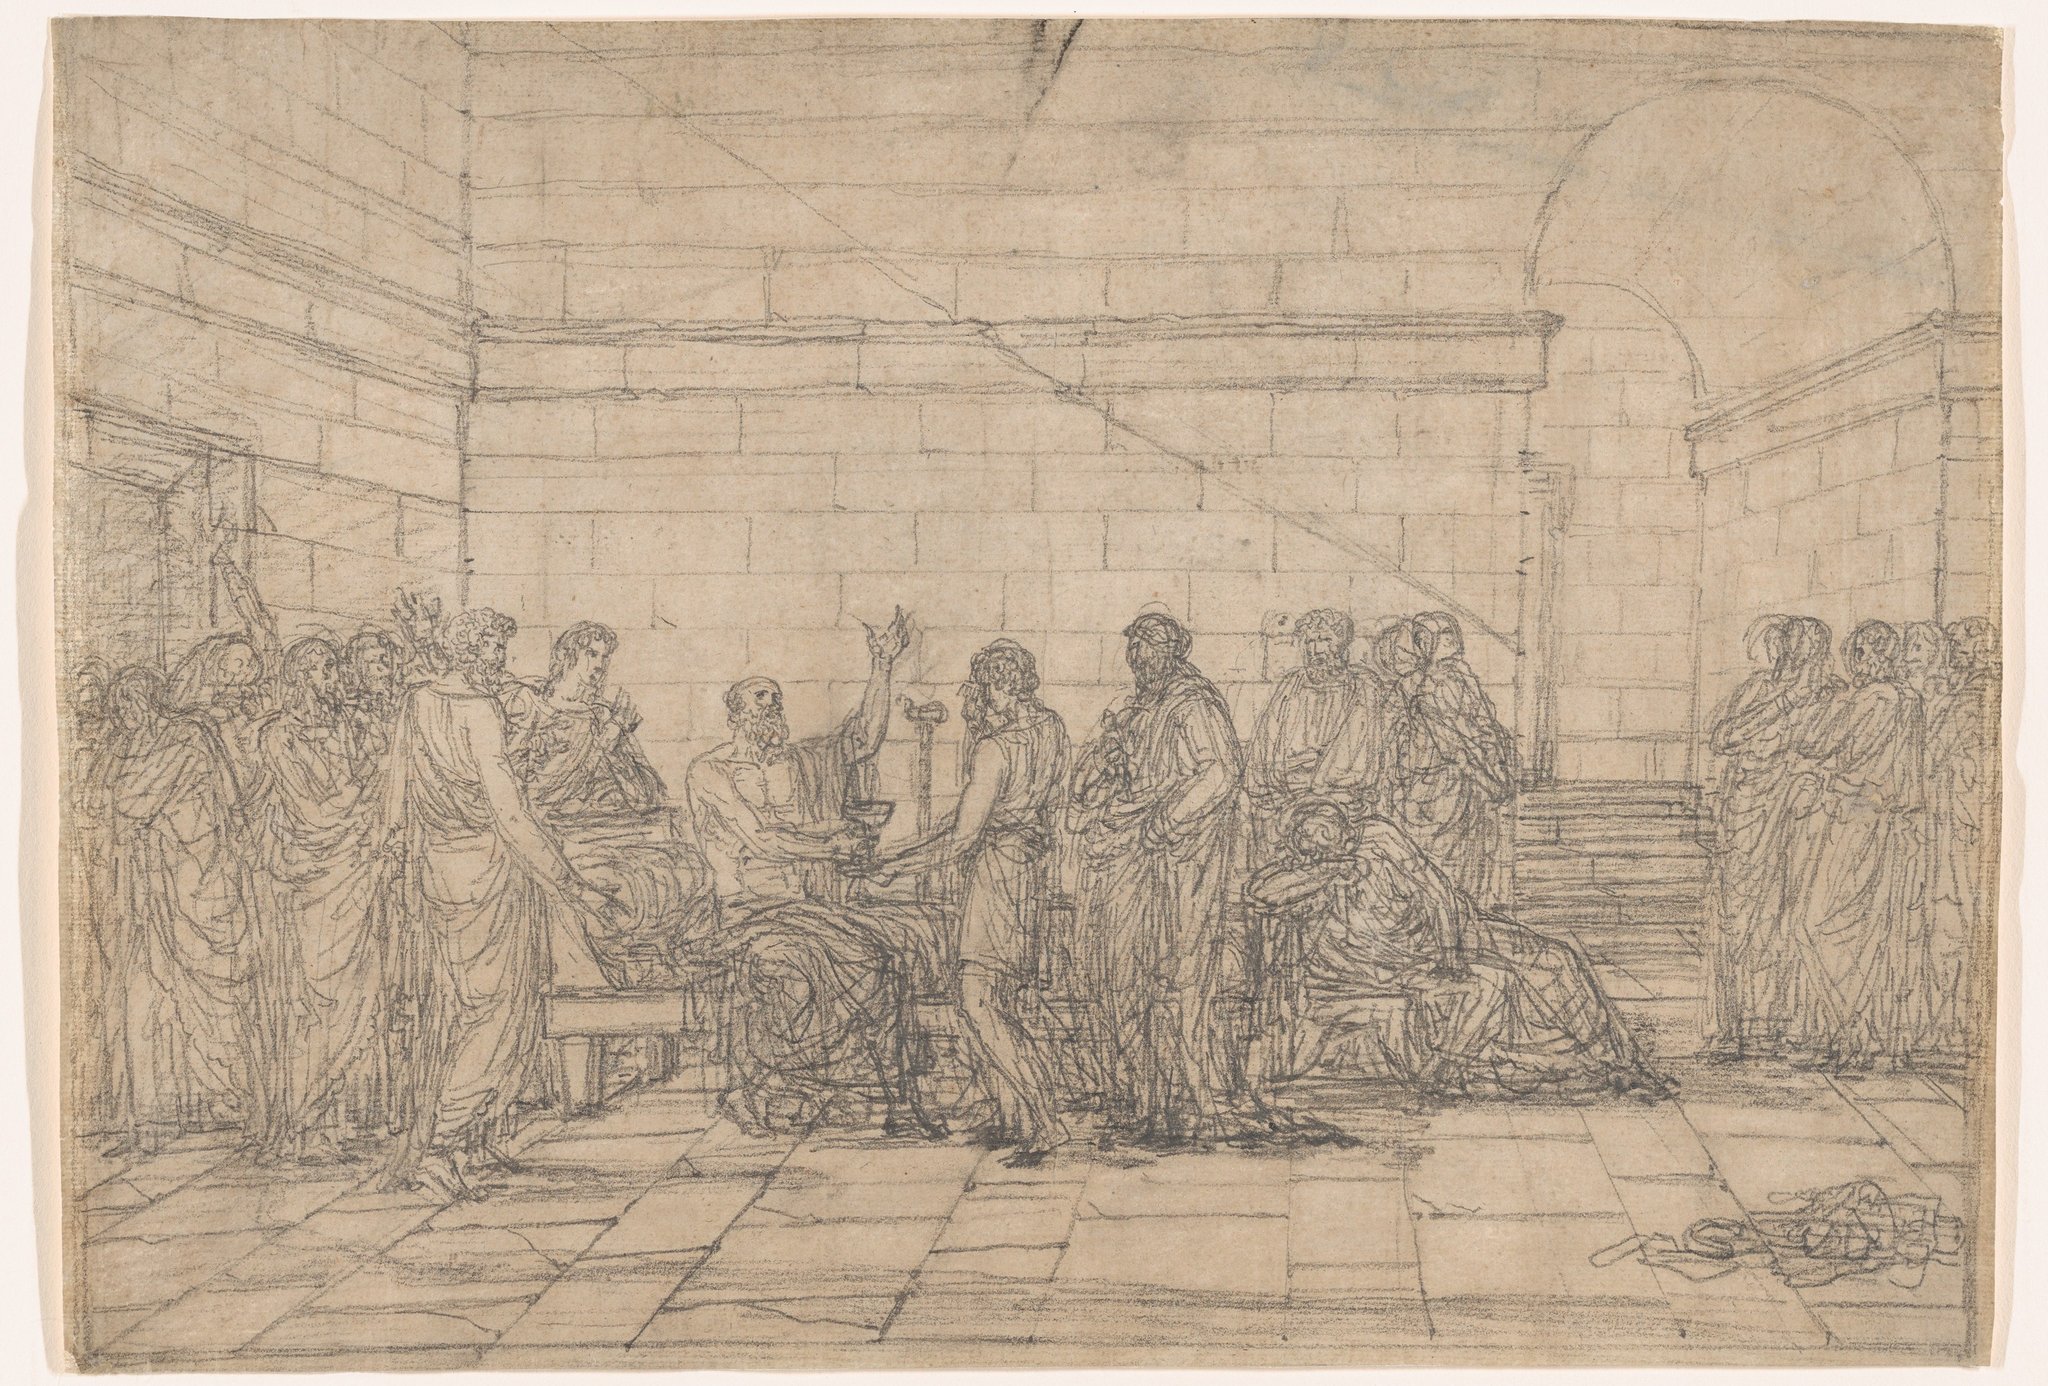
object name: drawing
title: Death of Socrates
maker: jean-baptiste joseph wicar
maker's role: artist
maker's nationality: french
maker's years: 1762-1834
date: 1782-1792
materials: chalk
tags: socrates,men,death